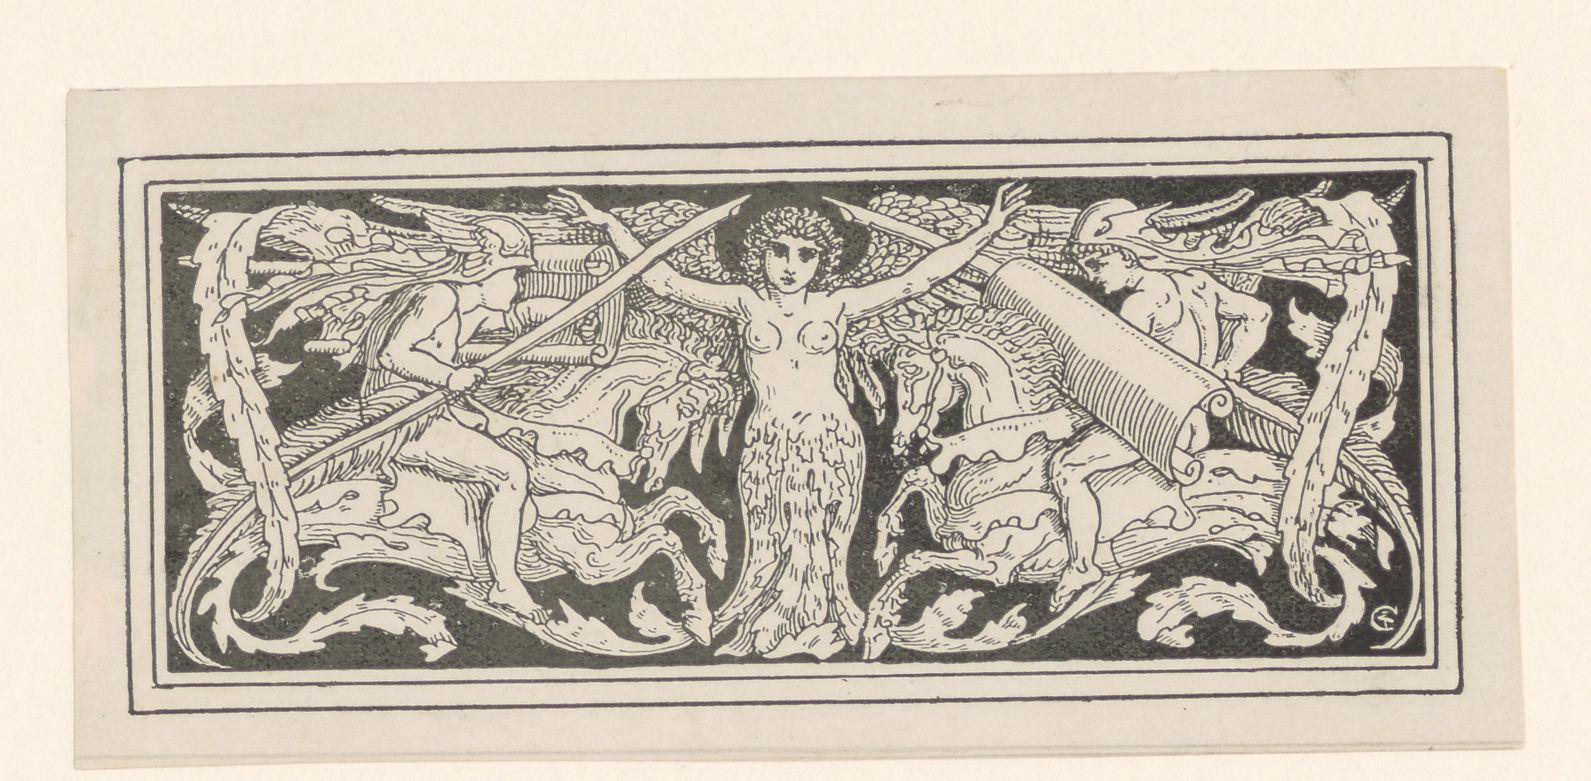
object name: print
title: Vrouwenfiguur met vleugels en twee ruiters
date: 1887-1893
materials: paper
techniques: engraving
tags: riding a horse, ass, or mule; rider, horseman, fabulous beings with wings - aa - female human figure, helved weapons, polearms (for striking, hacking, thrusting): lance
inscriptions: collector's mark: Lugt 2228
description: De prent is gebruikt in: Crane, Walter. The claims of decorative art. Londen: Lawrence & Bullen, 1892.